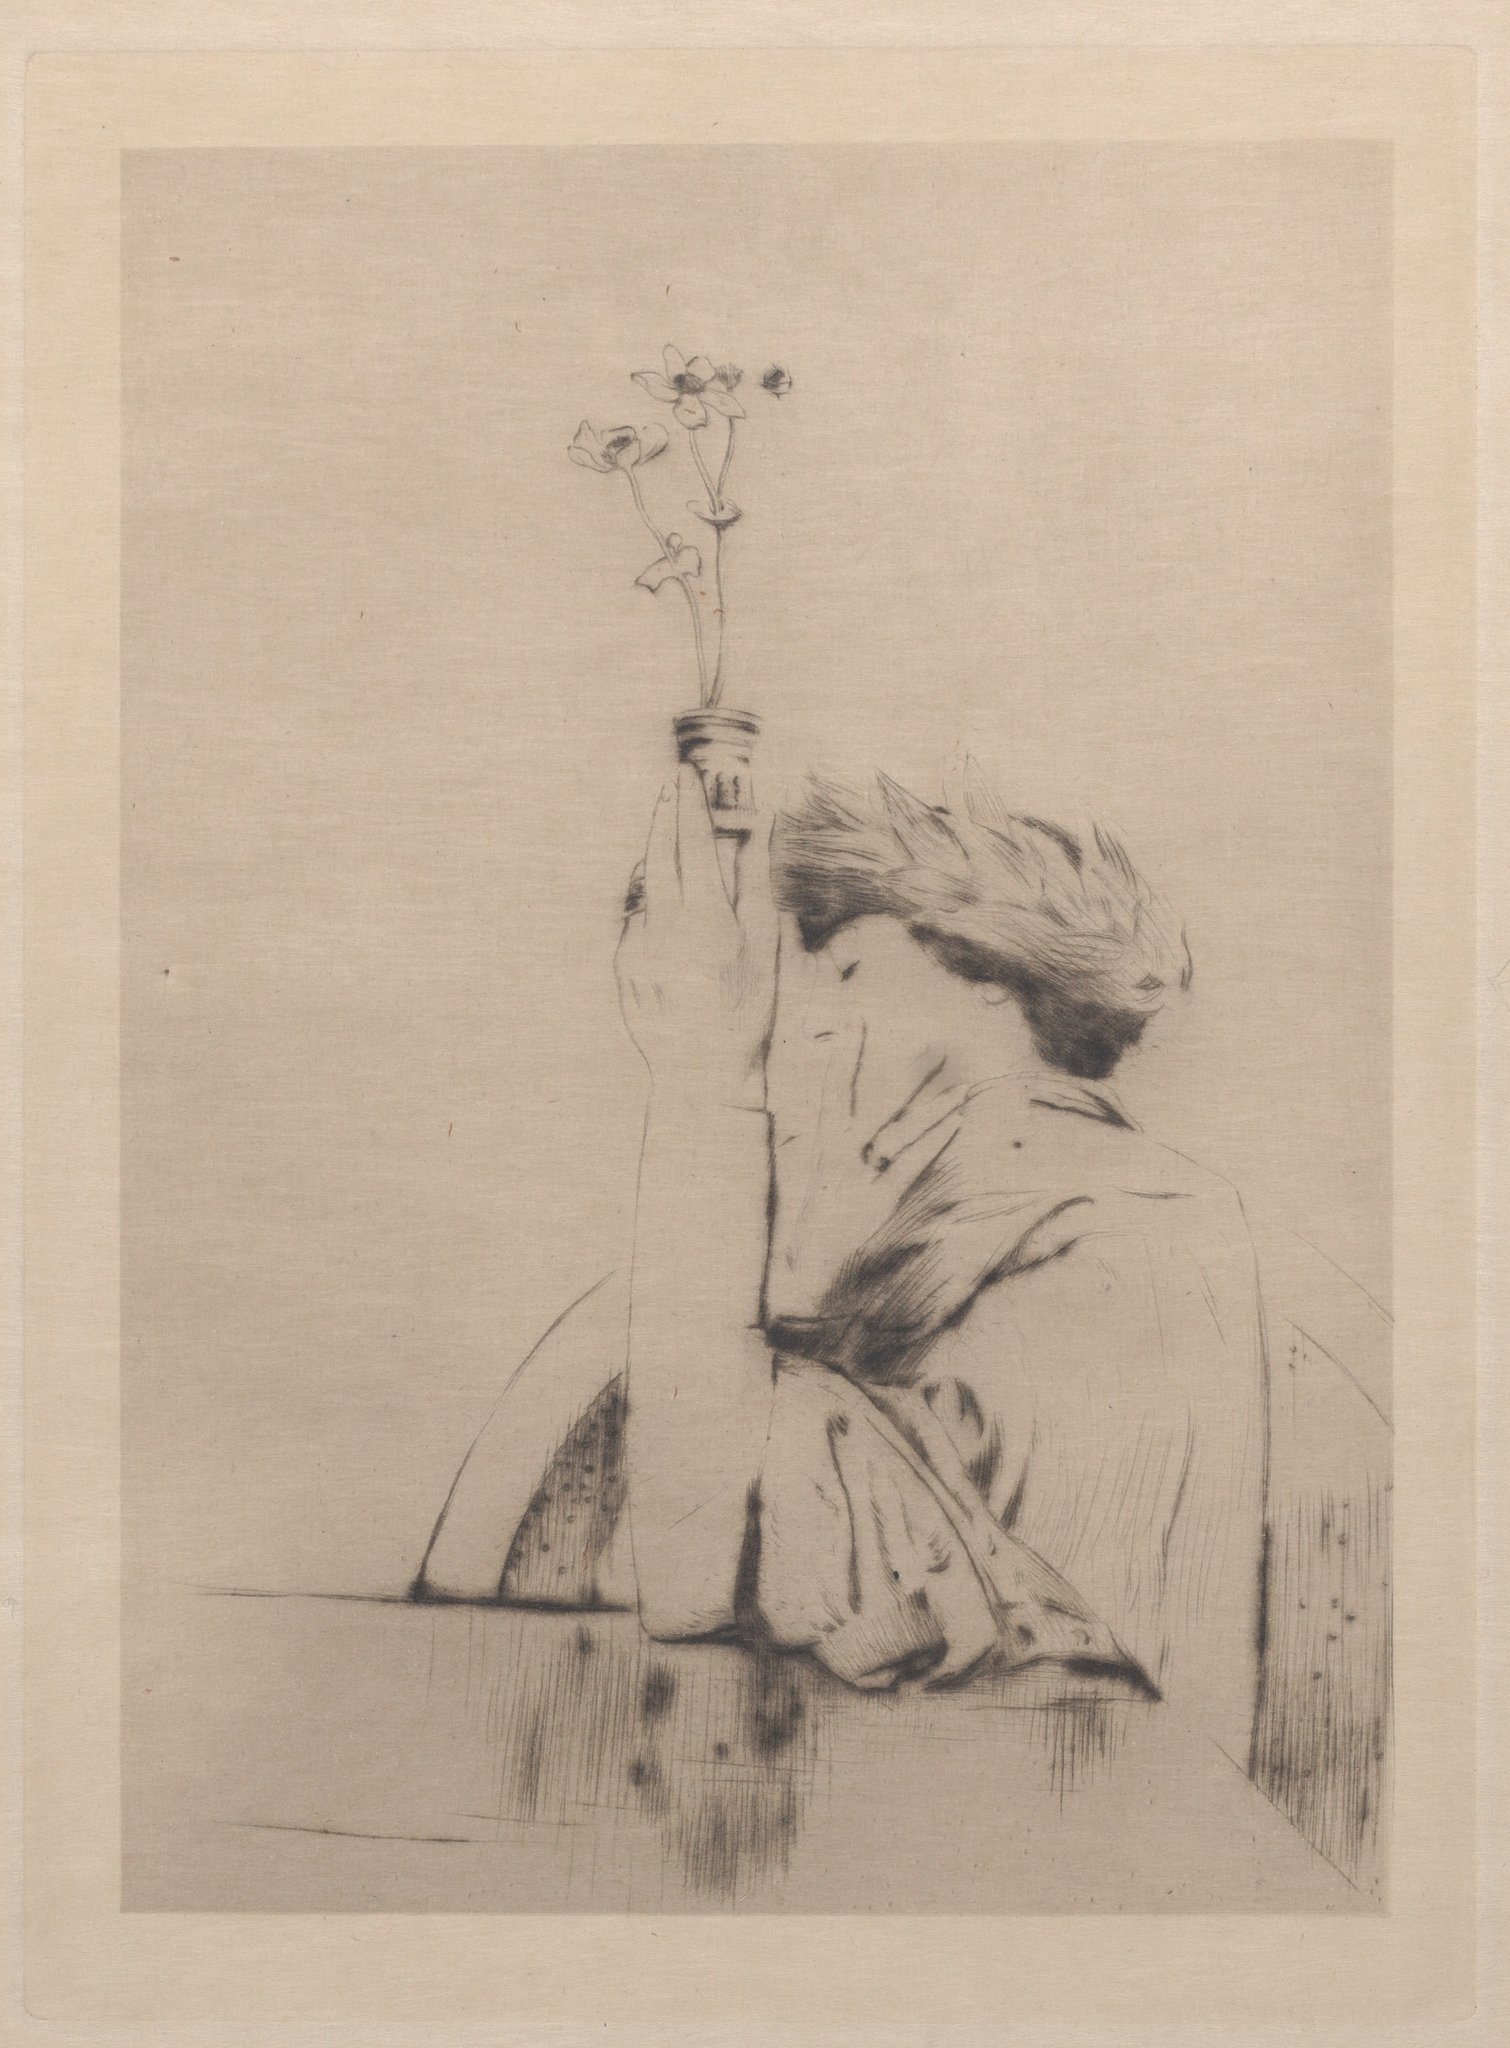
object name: print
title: An Offering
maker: fernand khnopff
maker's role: artist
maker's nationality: belgian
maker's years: 1858-1921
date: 1900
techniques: drypoint